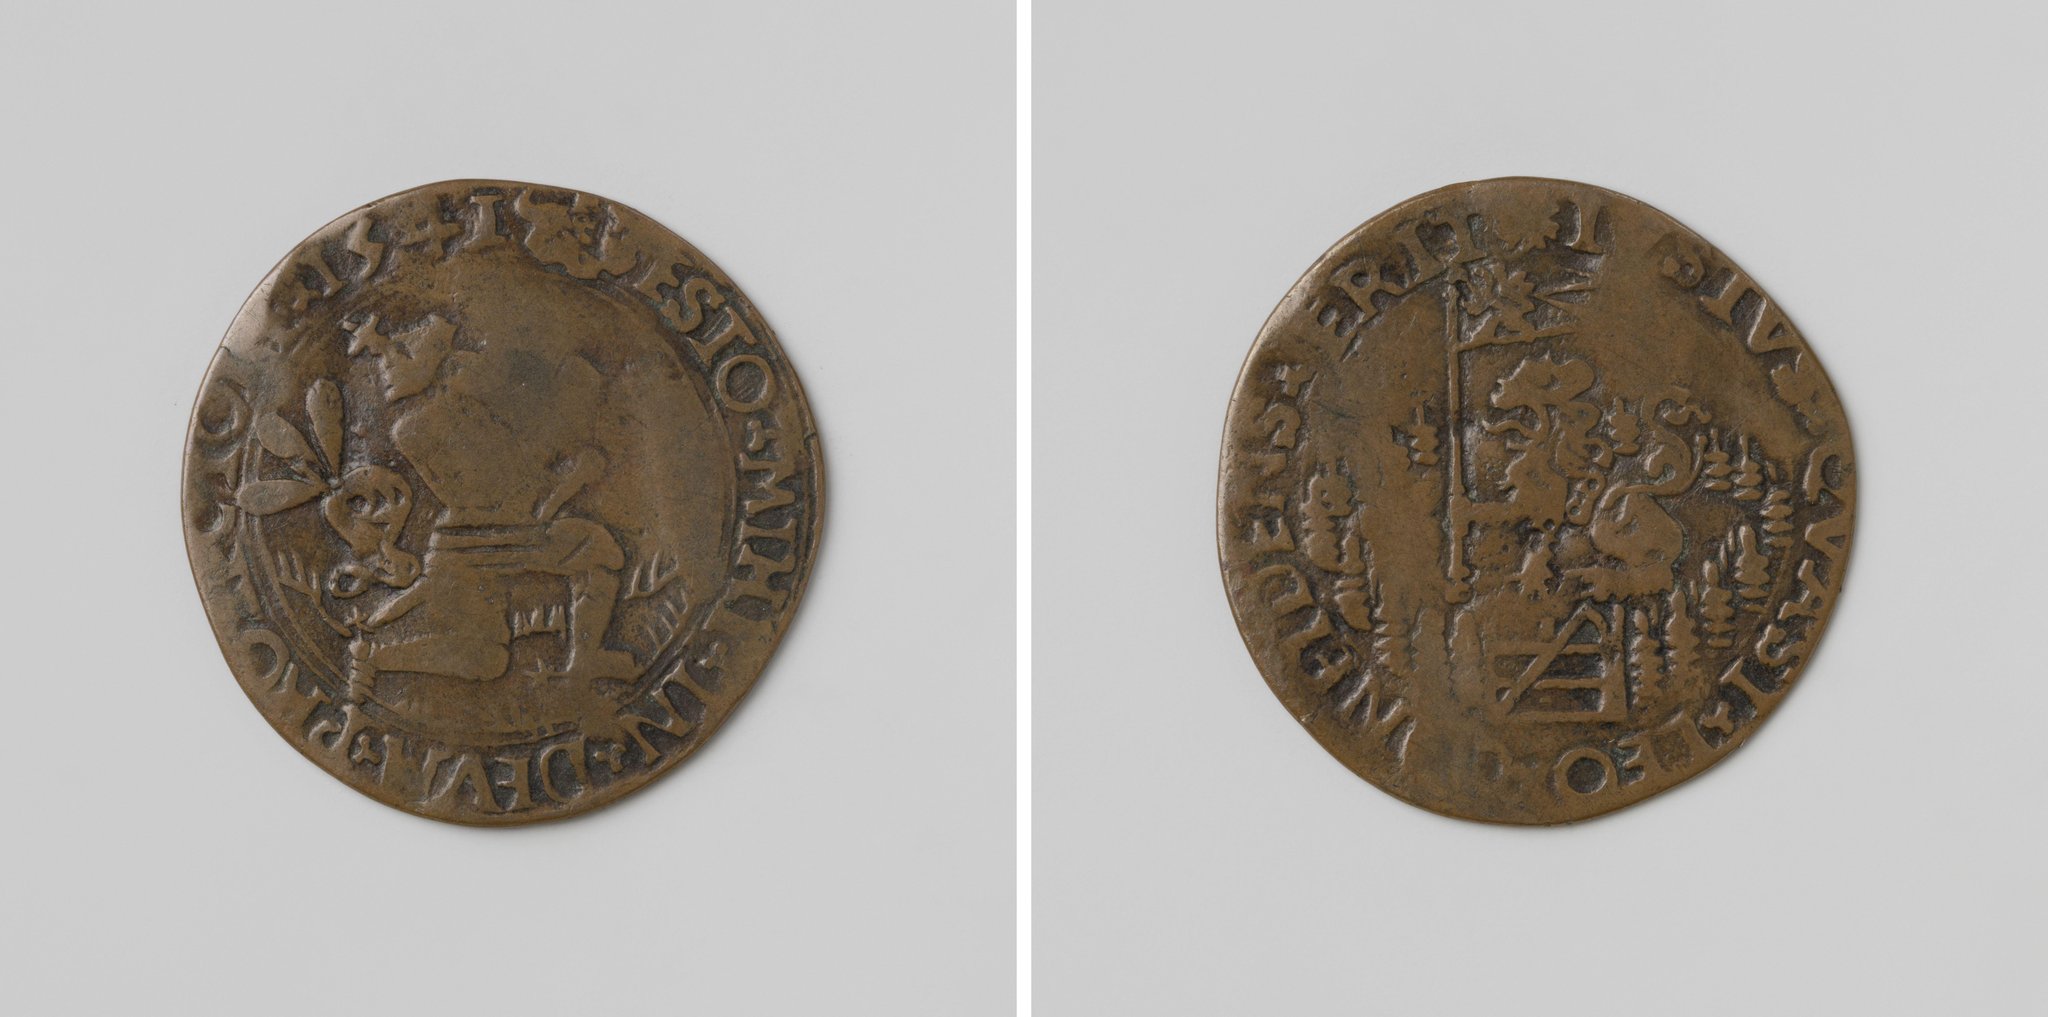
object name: jeton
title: Karel V, Duits keizer, bereidt zich voor op de expeditie tegen Algiers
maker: Anonymous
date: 1541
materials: copper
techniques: striking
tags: ghent, charles v (holy roman emperor and king of spain)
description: Koperen penning. Voorzijde: knielende Karel V bidt met blik hemelwaarts gericht binnen omschrift. Keerzijde: leeuw met standaard zittend in omheinde tuin binnen omschrift